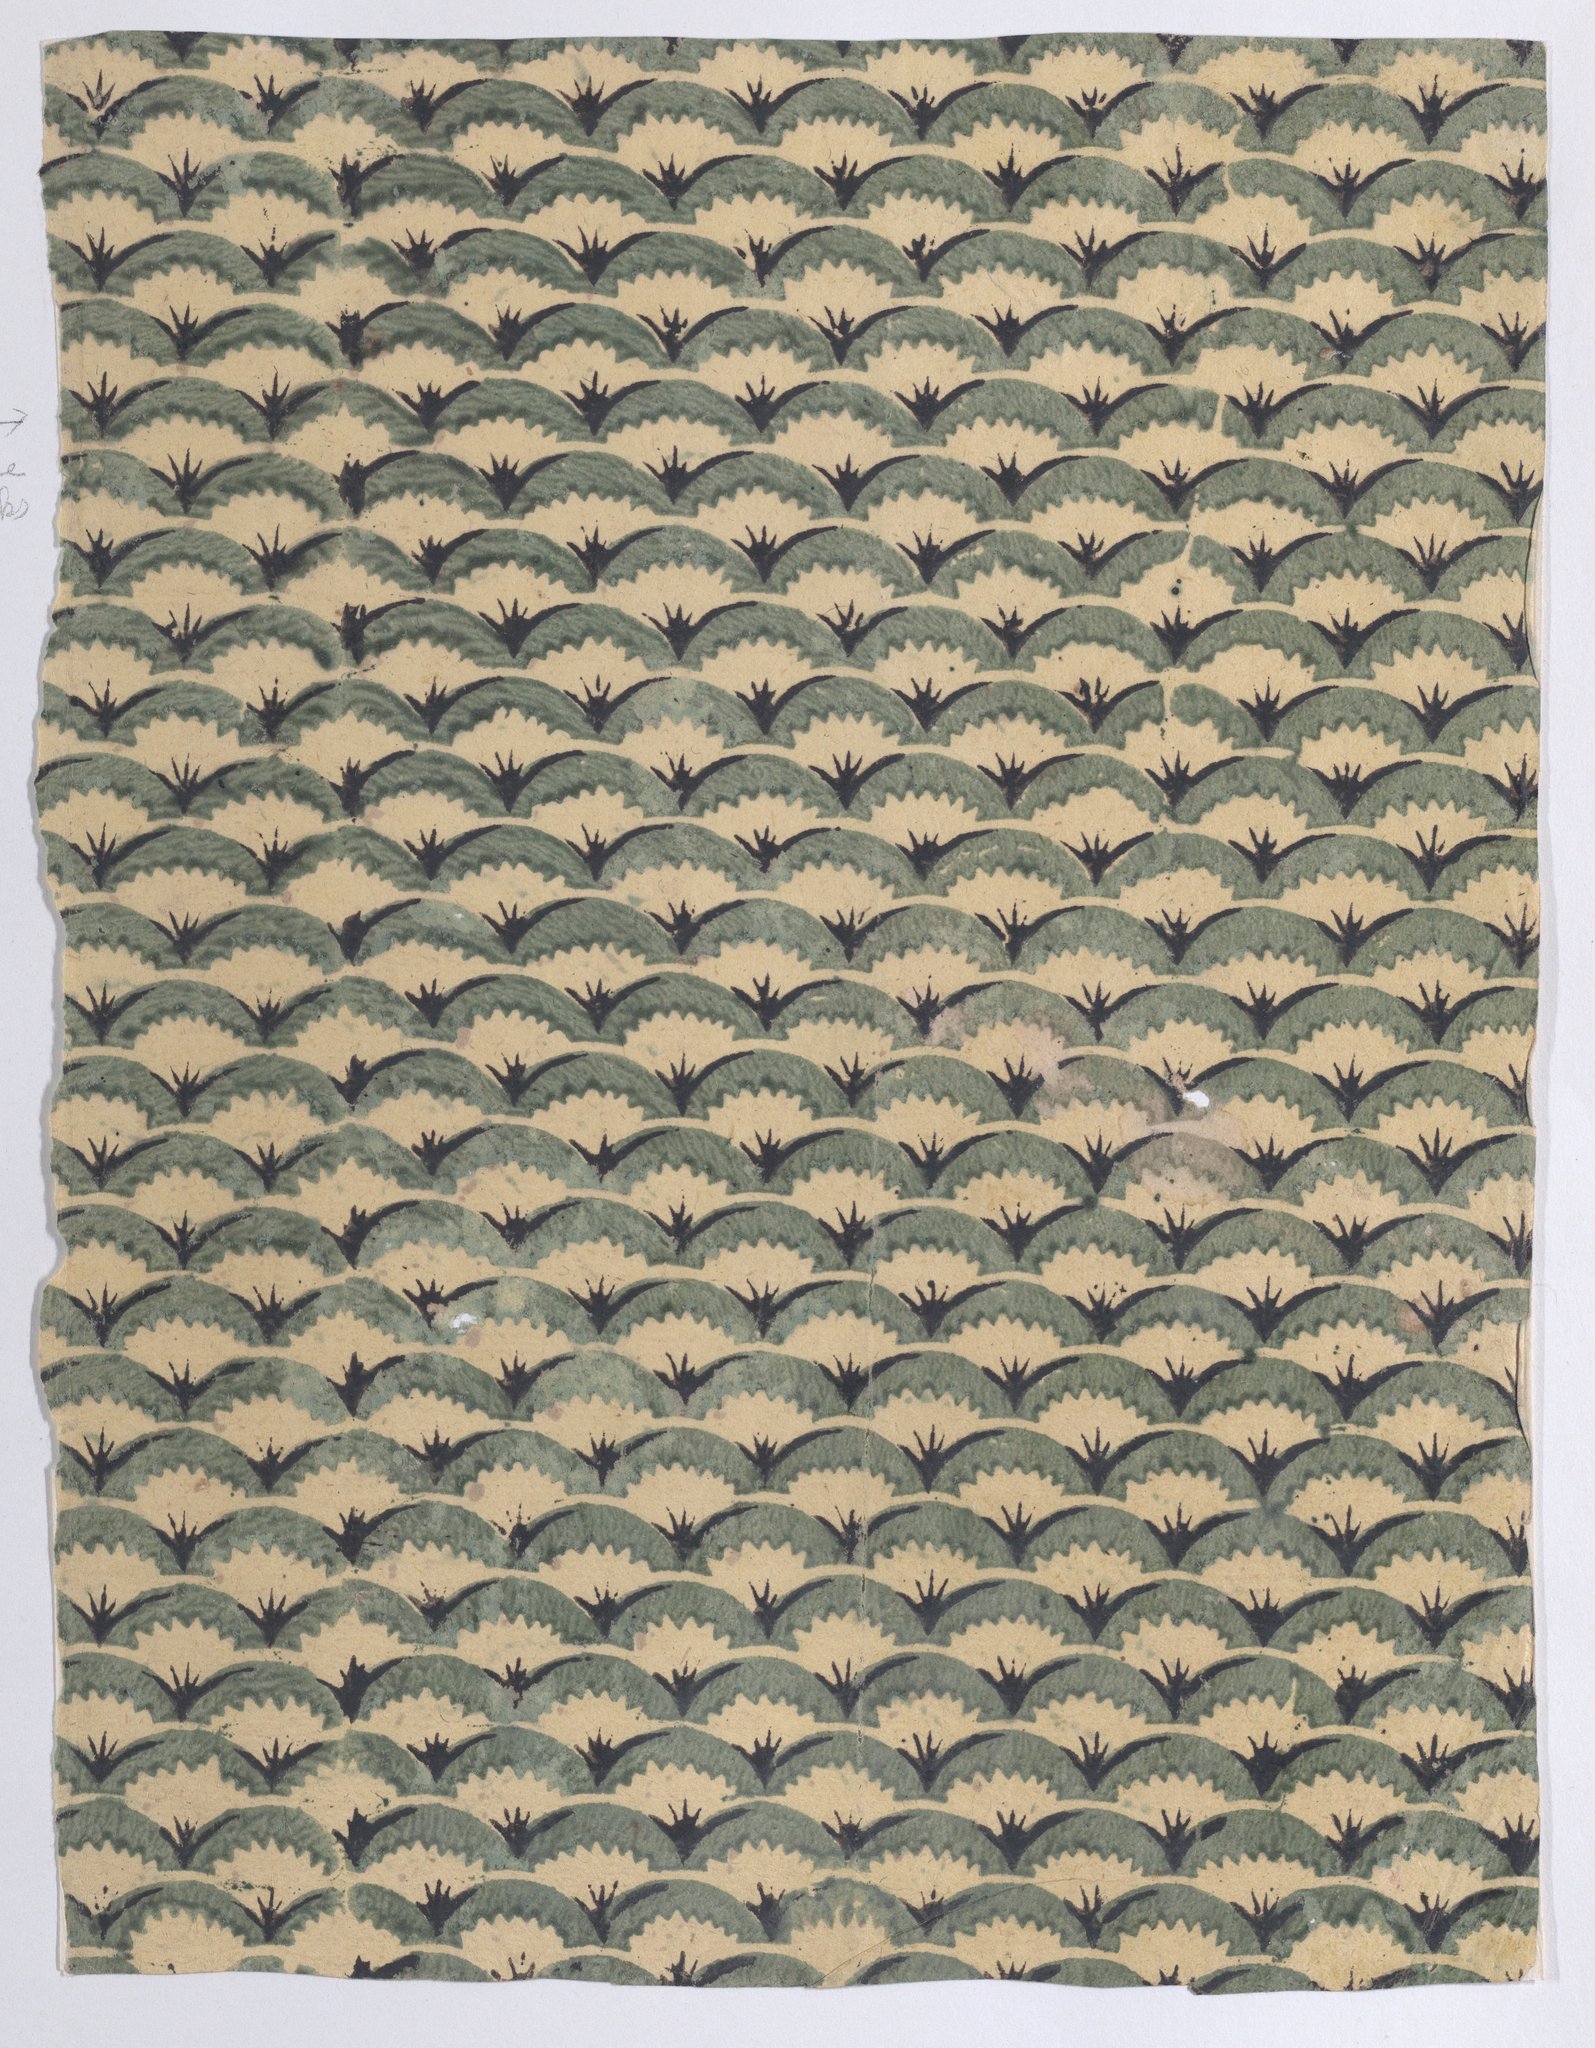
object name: print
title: Sheet with overall curved abstract pattern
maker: Anonymous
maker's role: artist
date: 1801-1900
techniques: relief print